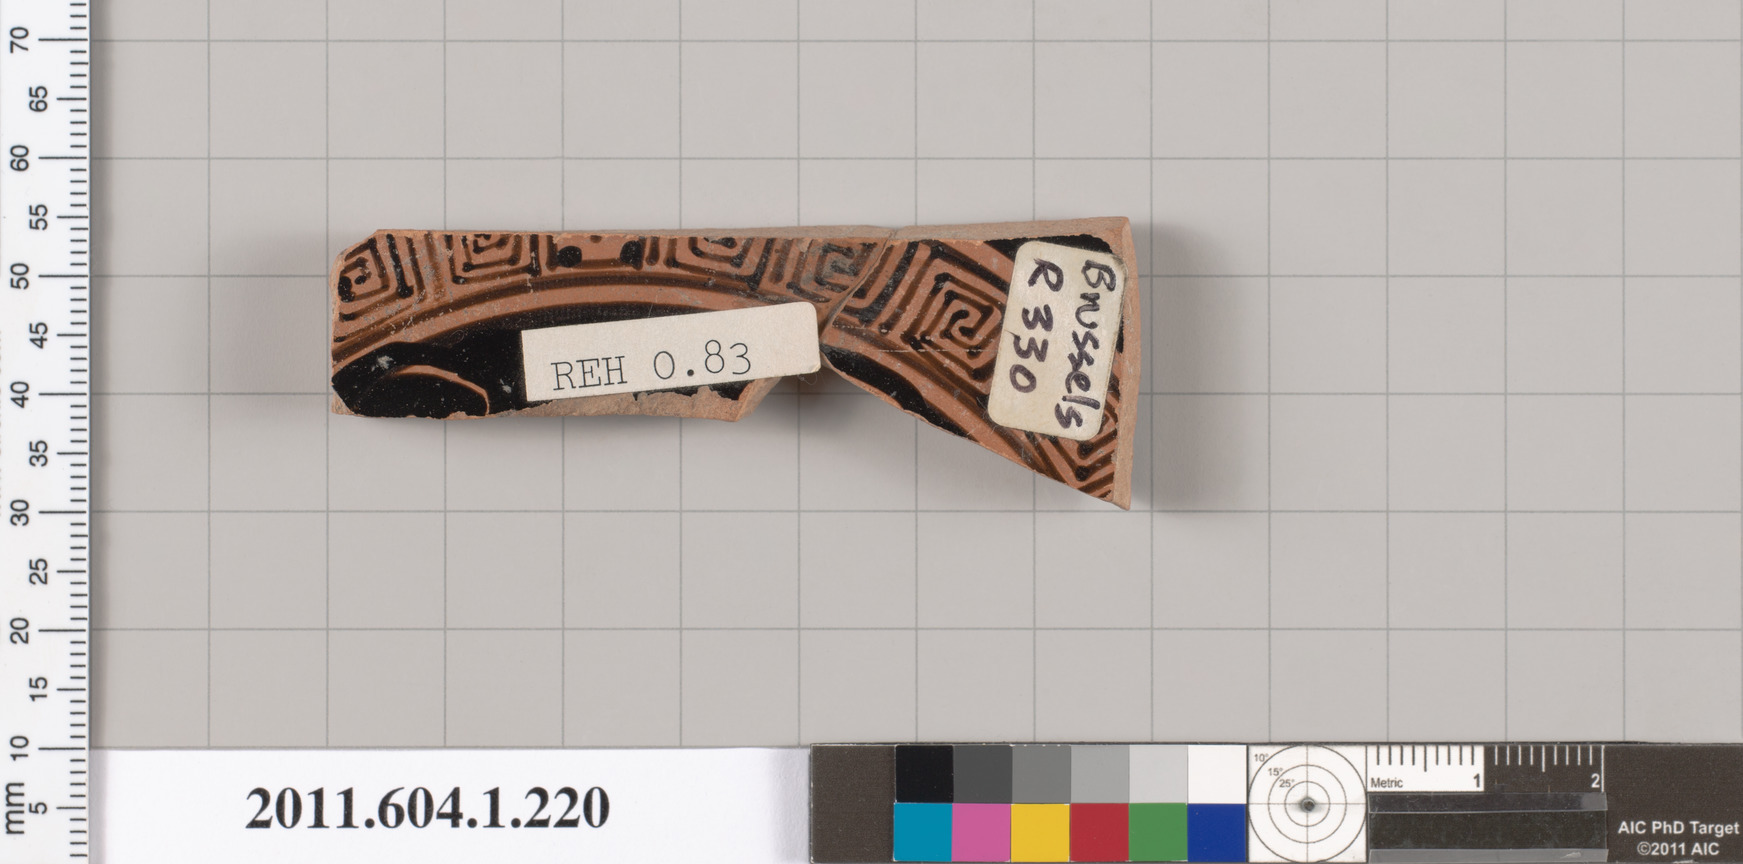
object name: kylix fragment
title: Terracotta fragment of a kylix (drinking cup)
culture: greek, attic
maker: painter of brussels r 330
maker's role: artist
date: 475-451 BCE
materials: terracotta